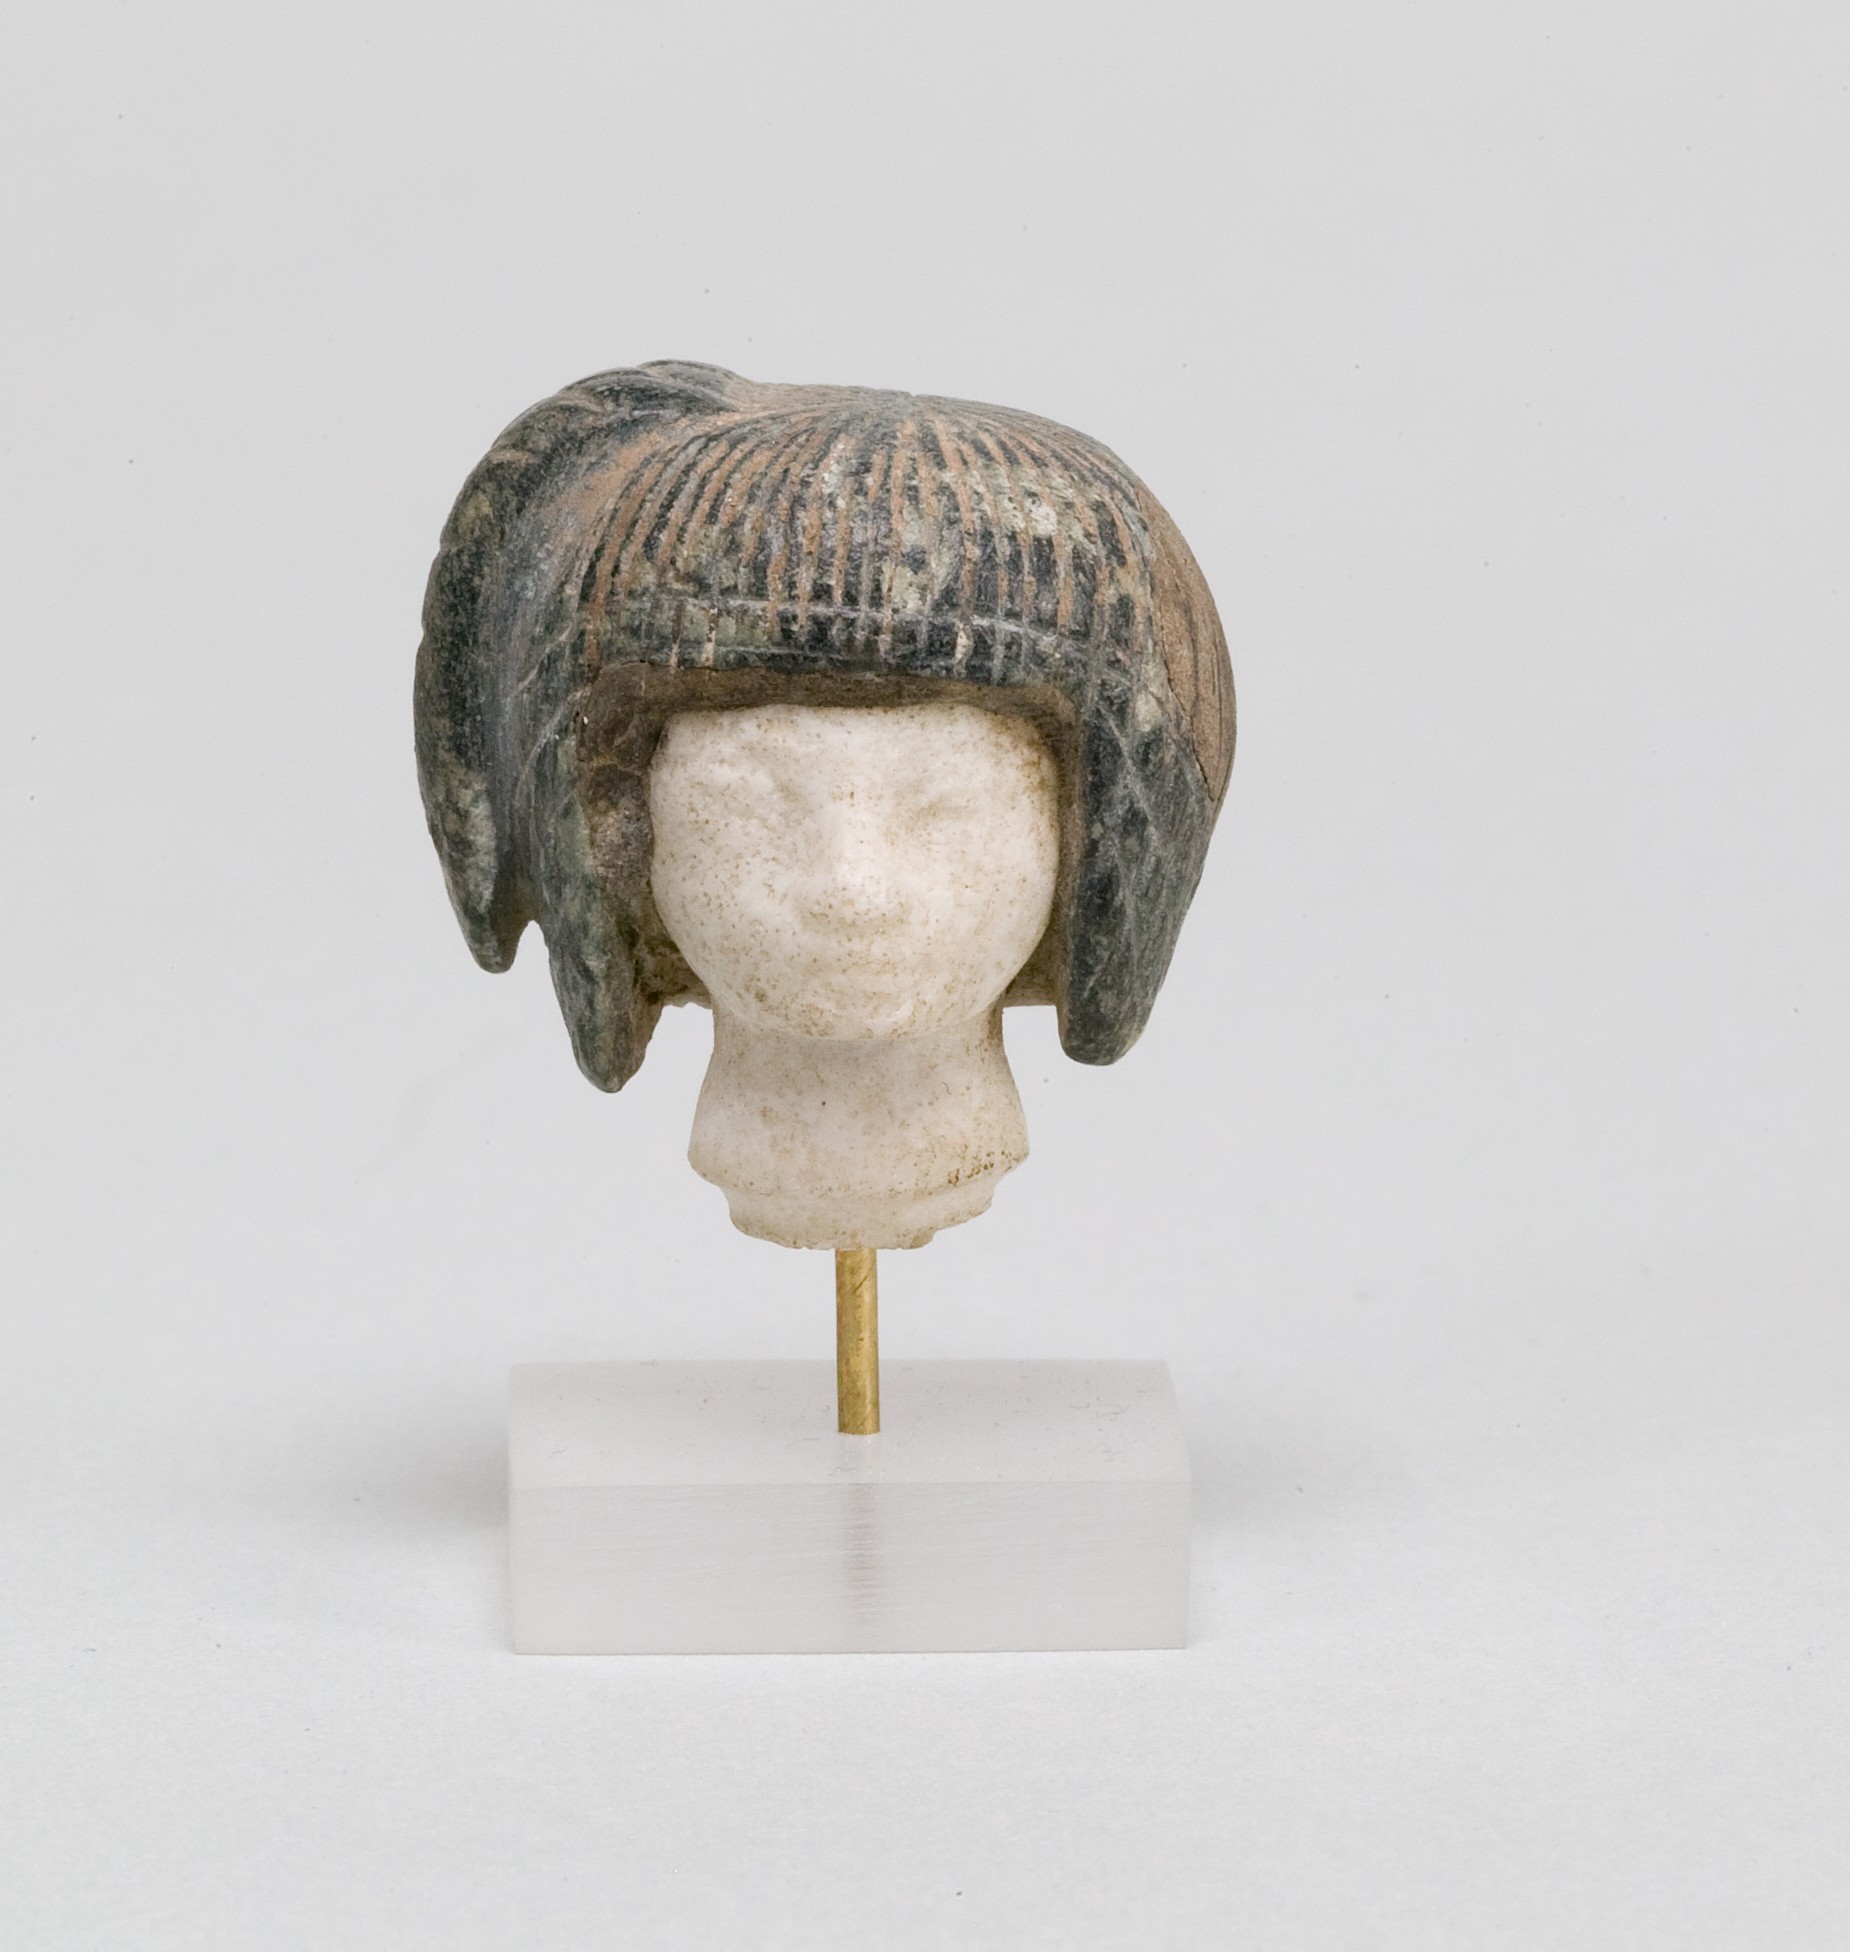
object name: head, girl, swimming, female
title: Head from a Spoon in the form of a Swimming Girl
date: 1390-1352 BCE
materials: stone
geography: egypt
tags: heads,girls